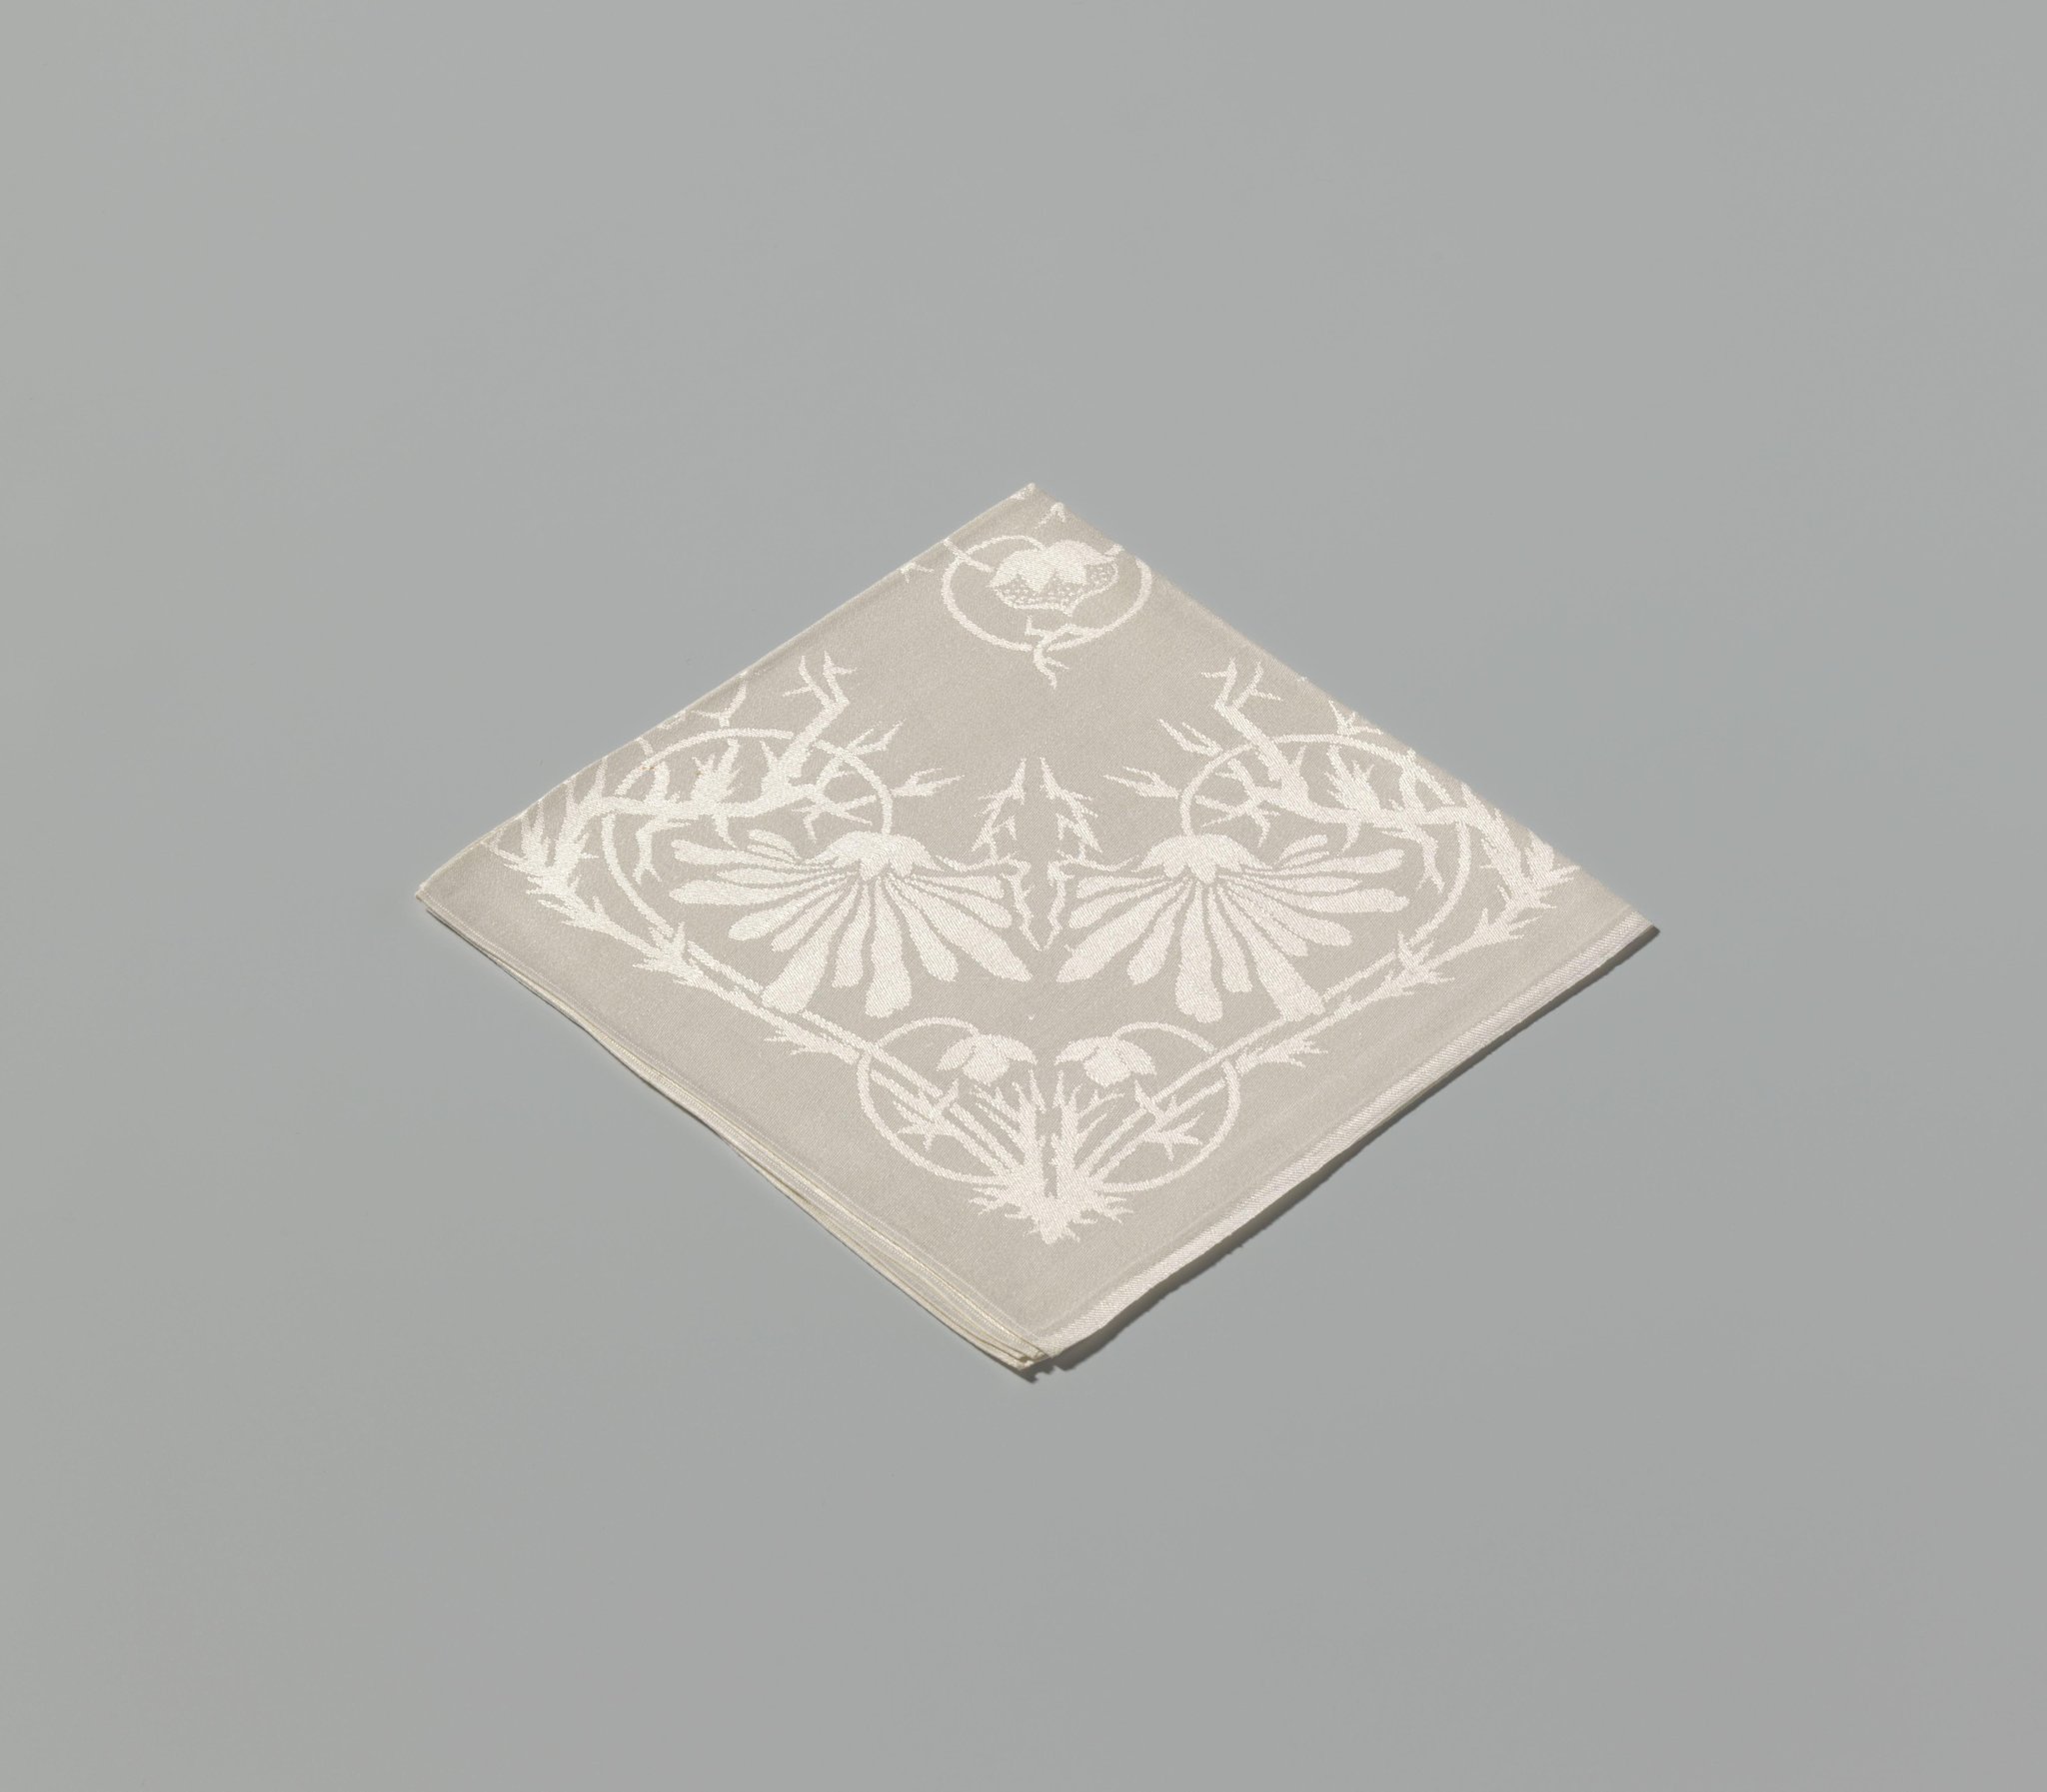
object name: vingerdoek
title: Vingerdoek van linnendamast met dessin Marguerite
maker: cornelis van der sluys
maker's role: print maker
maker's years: 1881-1944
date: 1904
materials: linen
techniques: damask, weave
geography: eindhoven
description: Vingerdoek van linnendamast met een bloempatroon: motief Marguerite, dessin nr. 500. De vingerdoek hoort bij elf vingerdoeken, dertien servetten en een tafellaken.